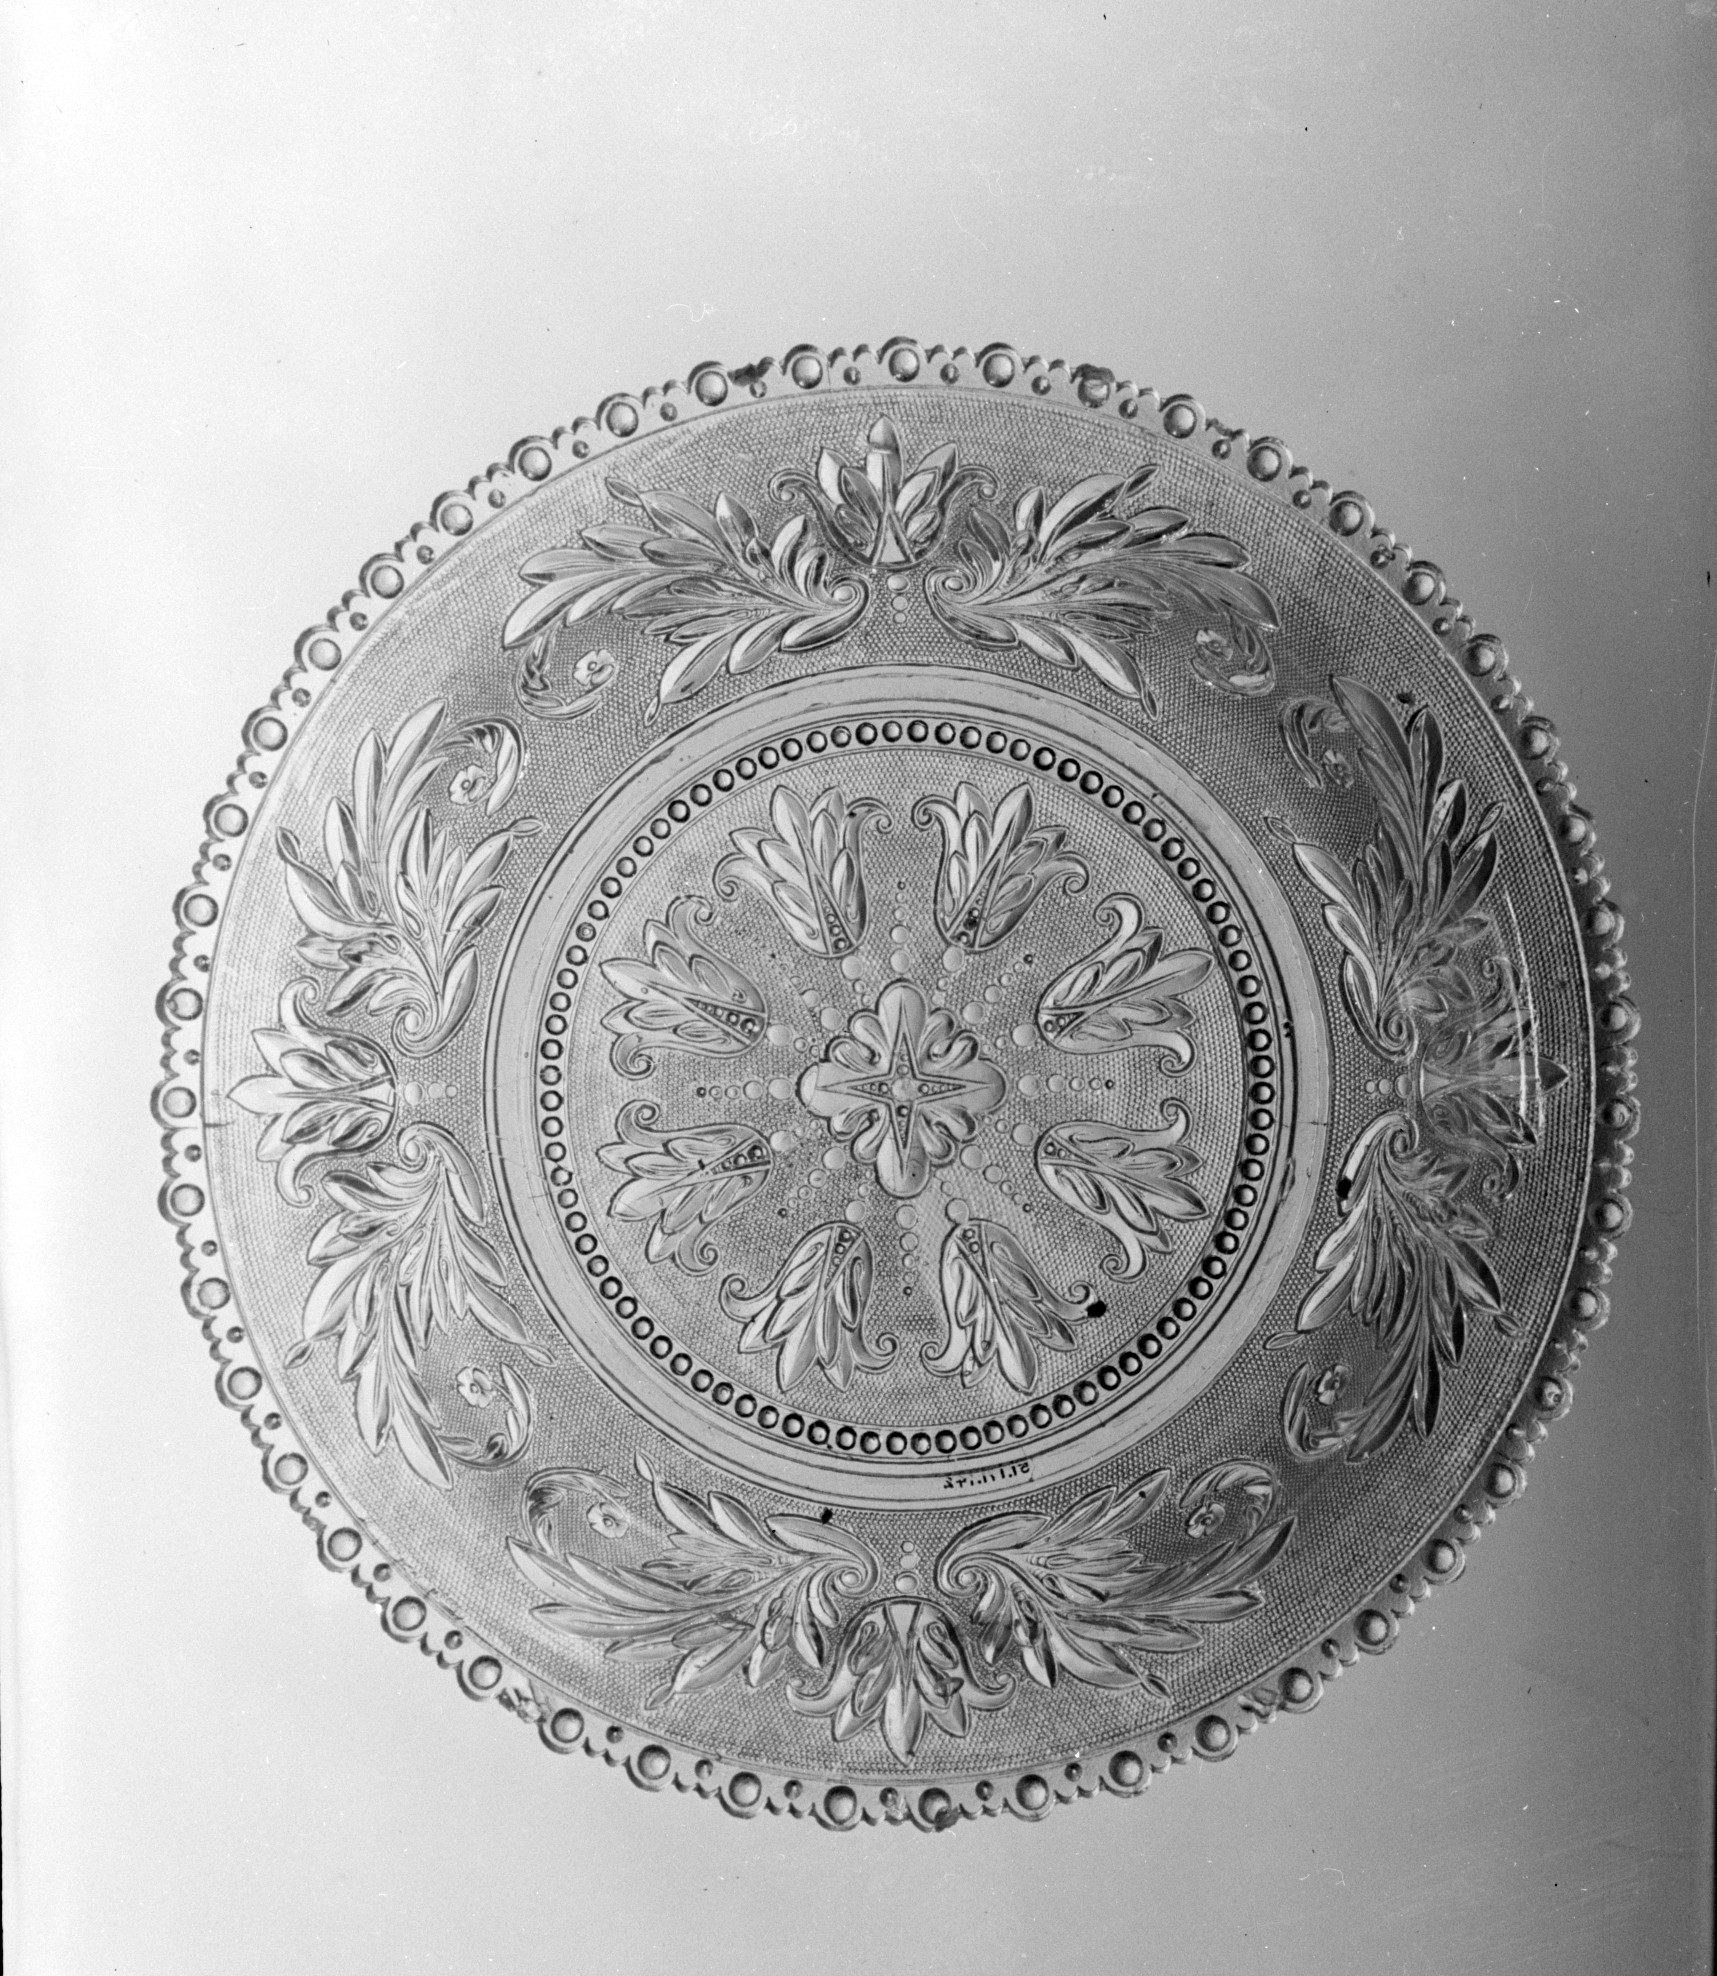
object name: bowl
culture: american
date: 1830-1845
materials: glass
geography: united states